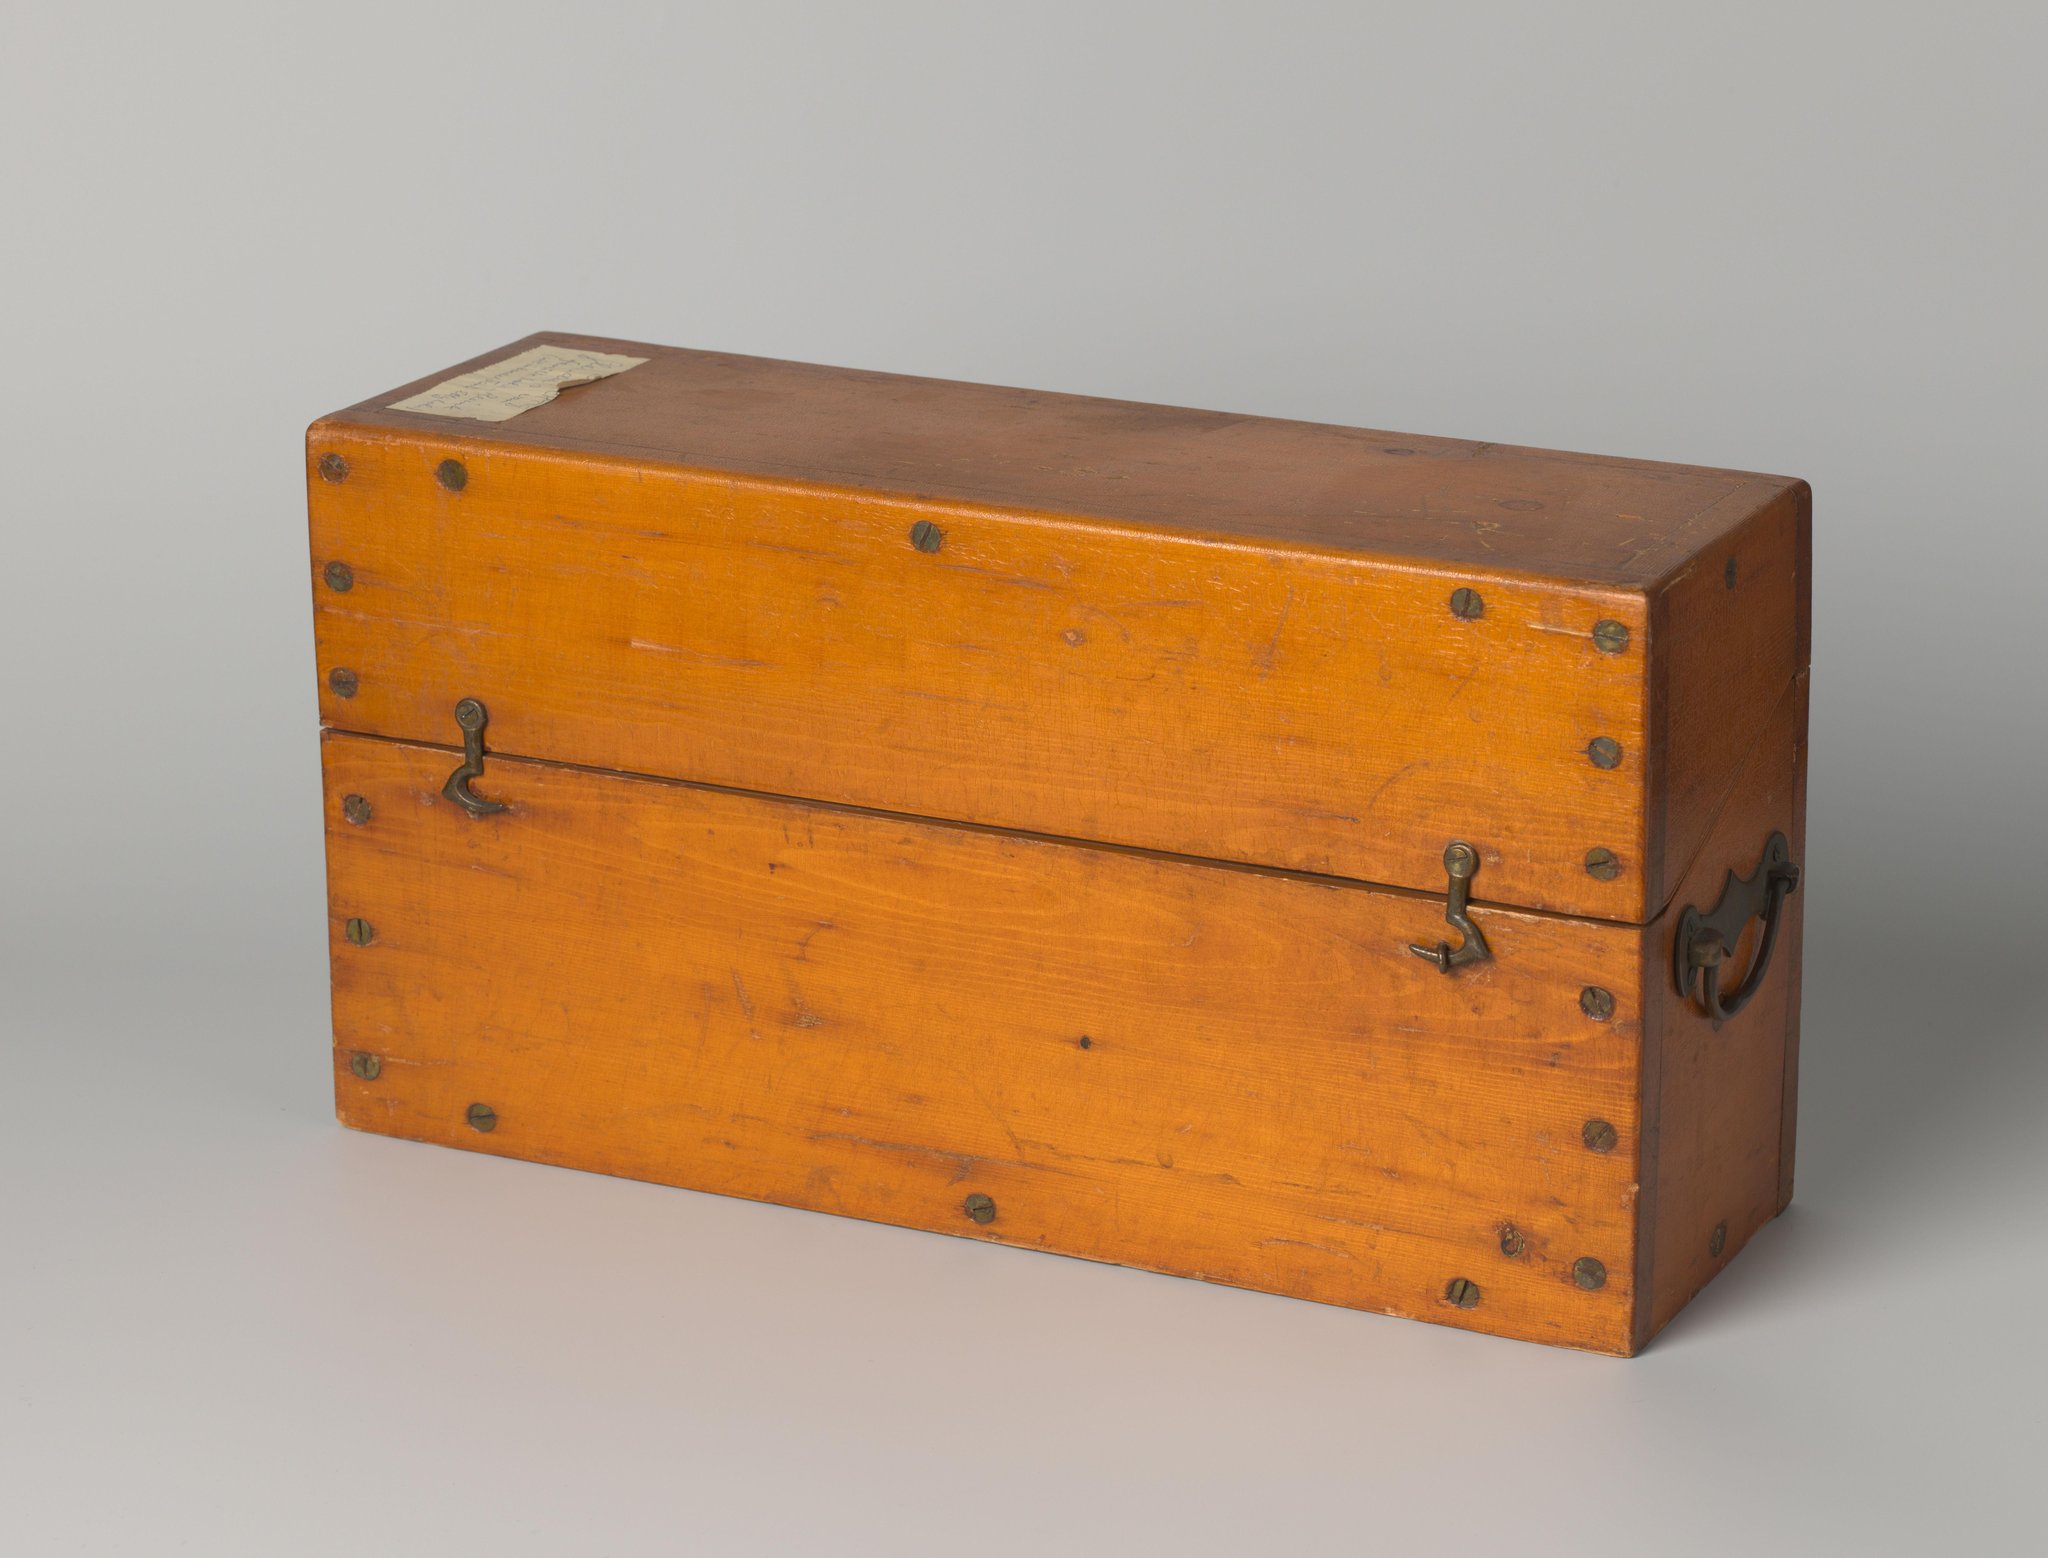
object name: chest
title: Lege houten kist voor 70 stereoglasdia's van Herman Lohr en Jet Resink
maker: Anonymous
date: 1905-1906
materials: wood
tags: amsterdam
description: Voor de nummering van de stereoglasdia's is de nummering van bijgevoegde lijst aangehouden. Enkele stereoglasdia's ontbreken, derhalve loopt de nummering niet door. De volgende nummers ontbreken: 23, 43, 59, 63, 69. Nummer 75 wordt niet genoemd op de lijst.